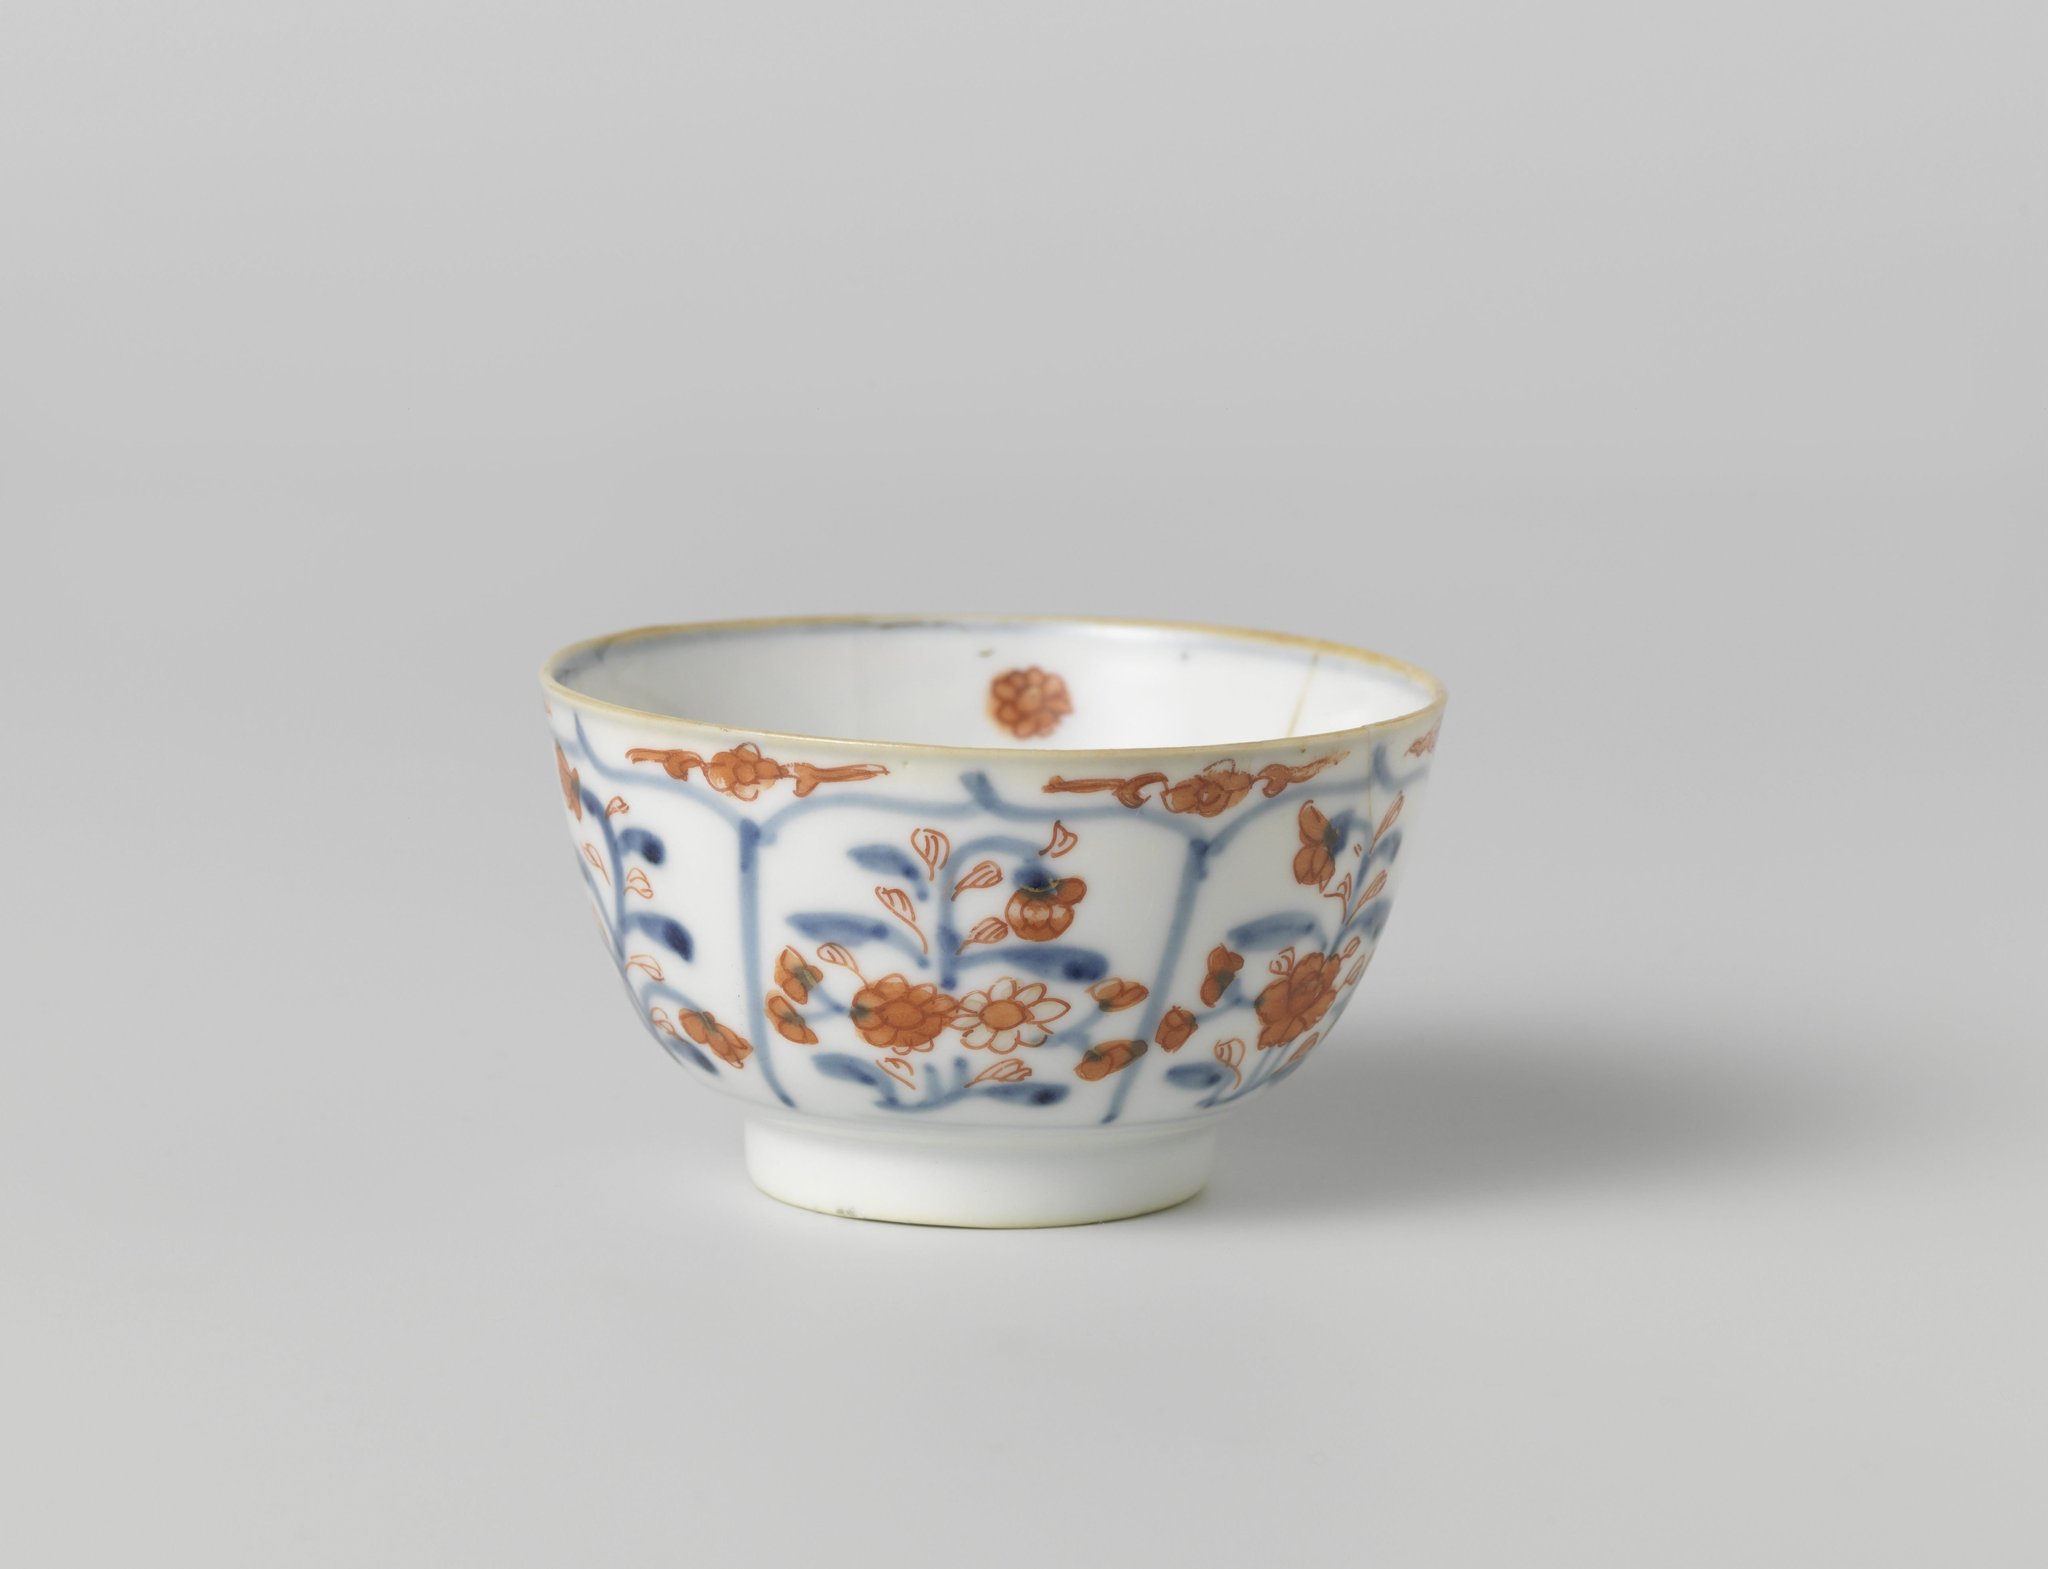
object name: kop en schotel, kop en schotel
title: Cup with petal-shaped panel around a central medallion, filled with flower sprays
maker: Anonymous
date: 1750-1774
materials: cobalt, glaze, gold, paint, porcelain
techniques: firing, gilding, turning, vitrification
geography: china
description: Imari. Beschilderd met vakken waarin takjes in blauw, rood en goud.